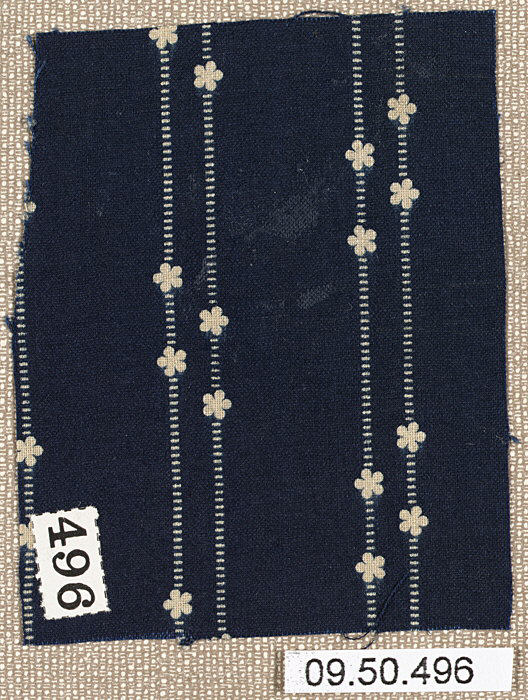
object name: piece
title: Piece (one of 13)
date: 1801-1900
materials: cotton